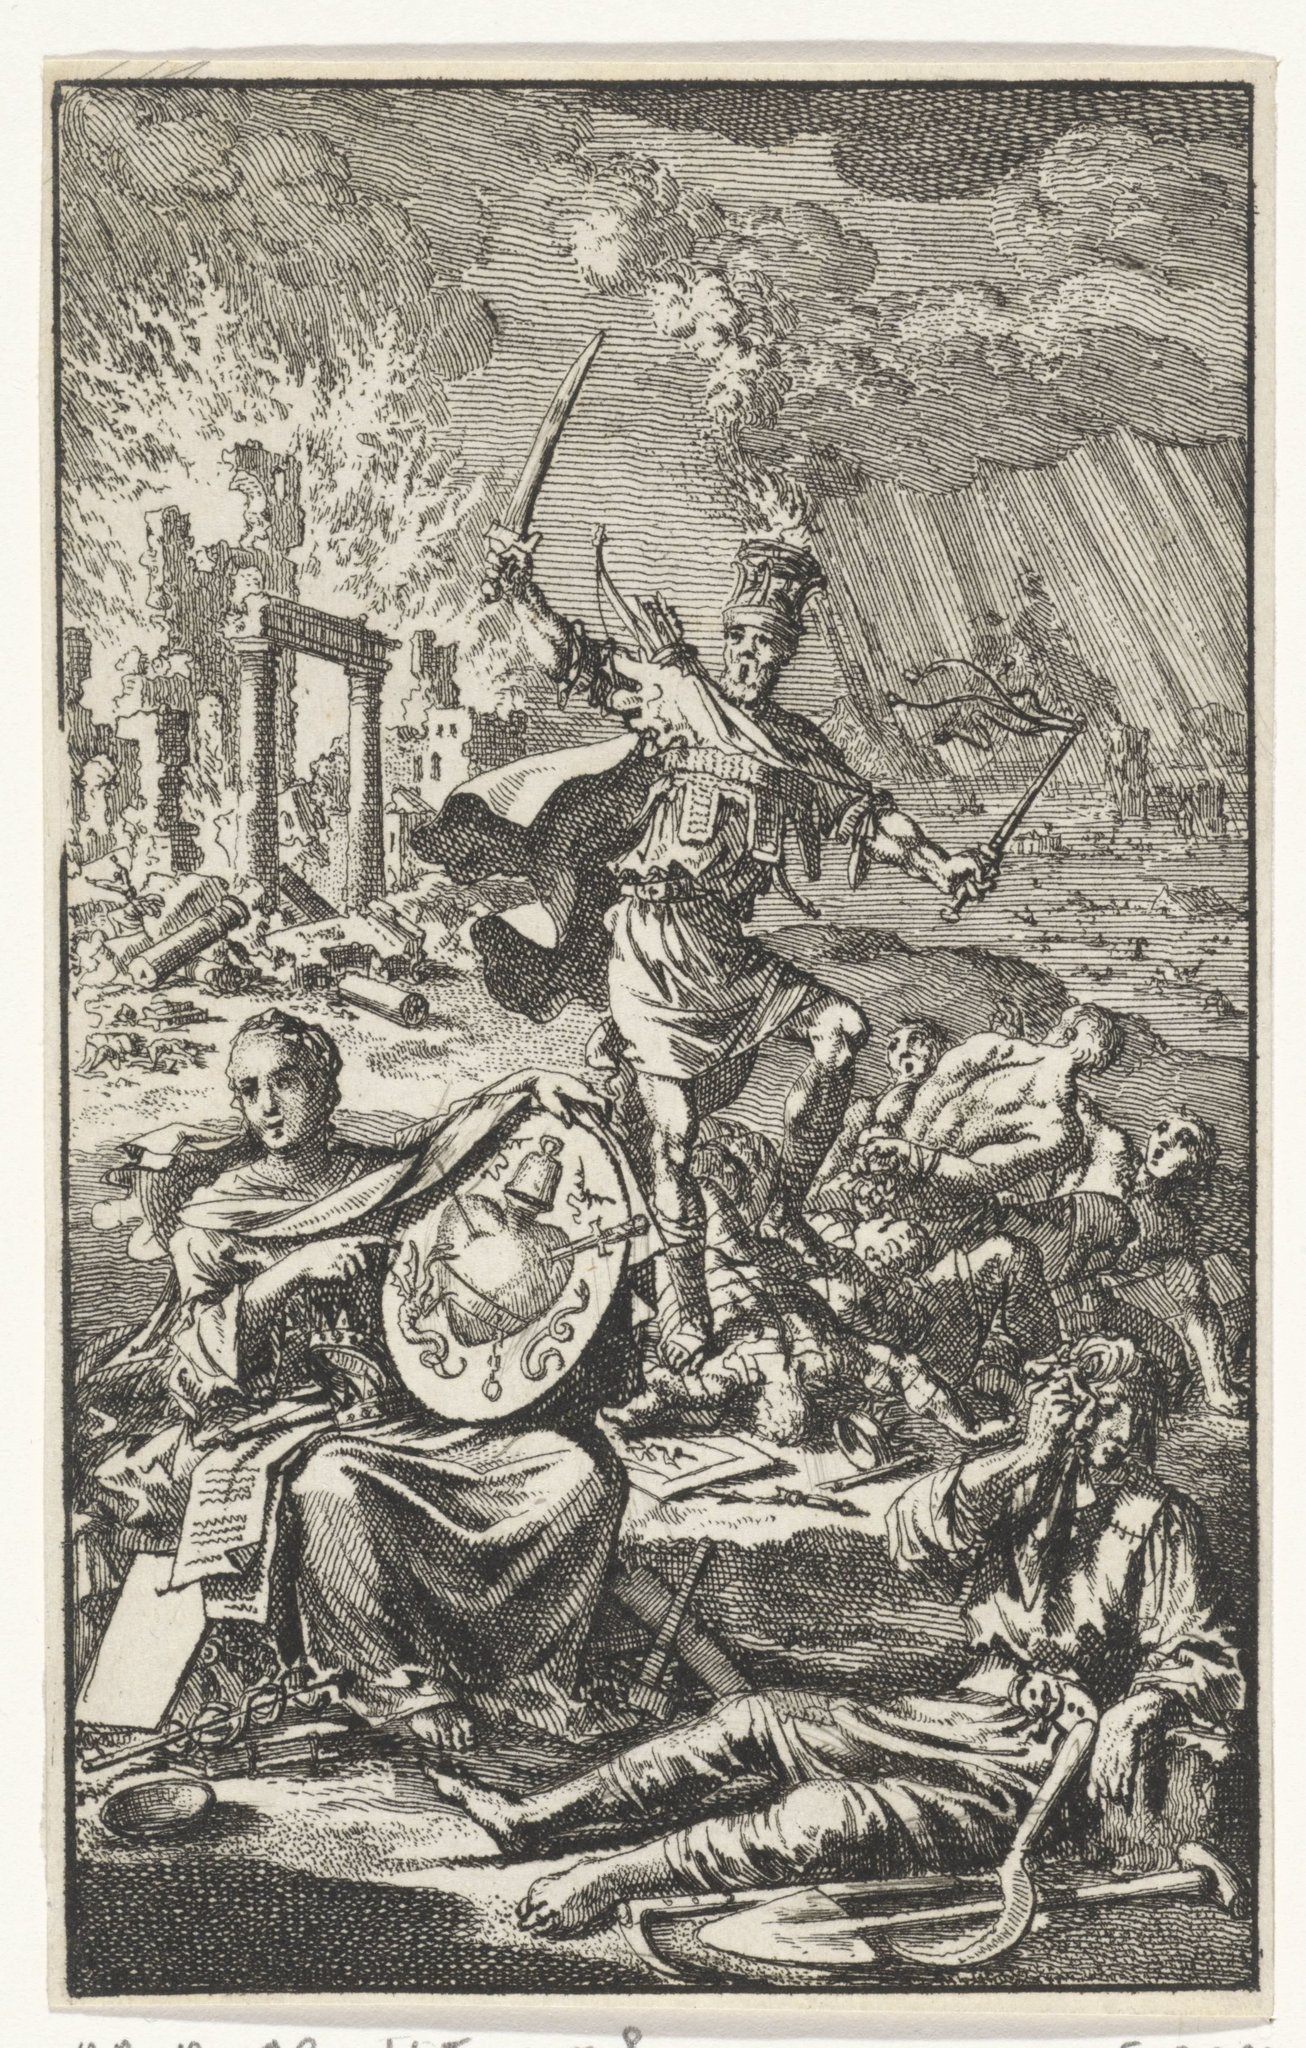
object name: print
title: Geweld vertrapt de overwonnenen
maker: jan luyken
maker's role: draughtsman, print maker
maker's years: 1649-1712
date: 1706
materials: paper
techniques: etching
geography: amsterdam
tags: heart symbolism, the defeated before the victor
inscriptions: collector's mark: Lugt 2228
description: Proefdruk voor: Bouman, Herkules. Waereld vol stryd. Amsterdam: Jacob van Royen, 1706.